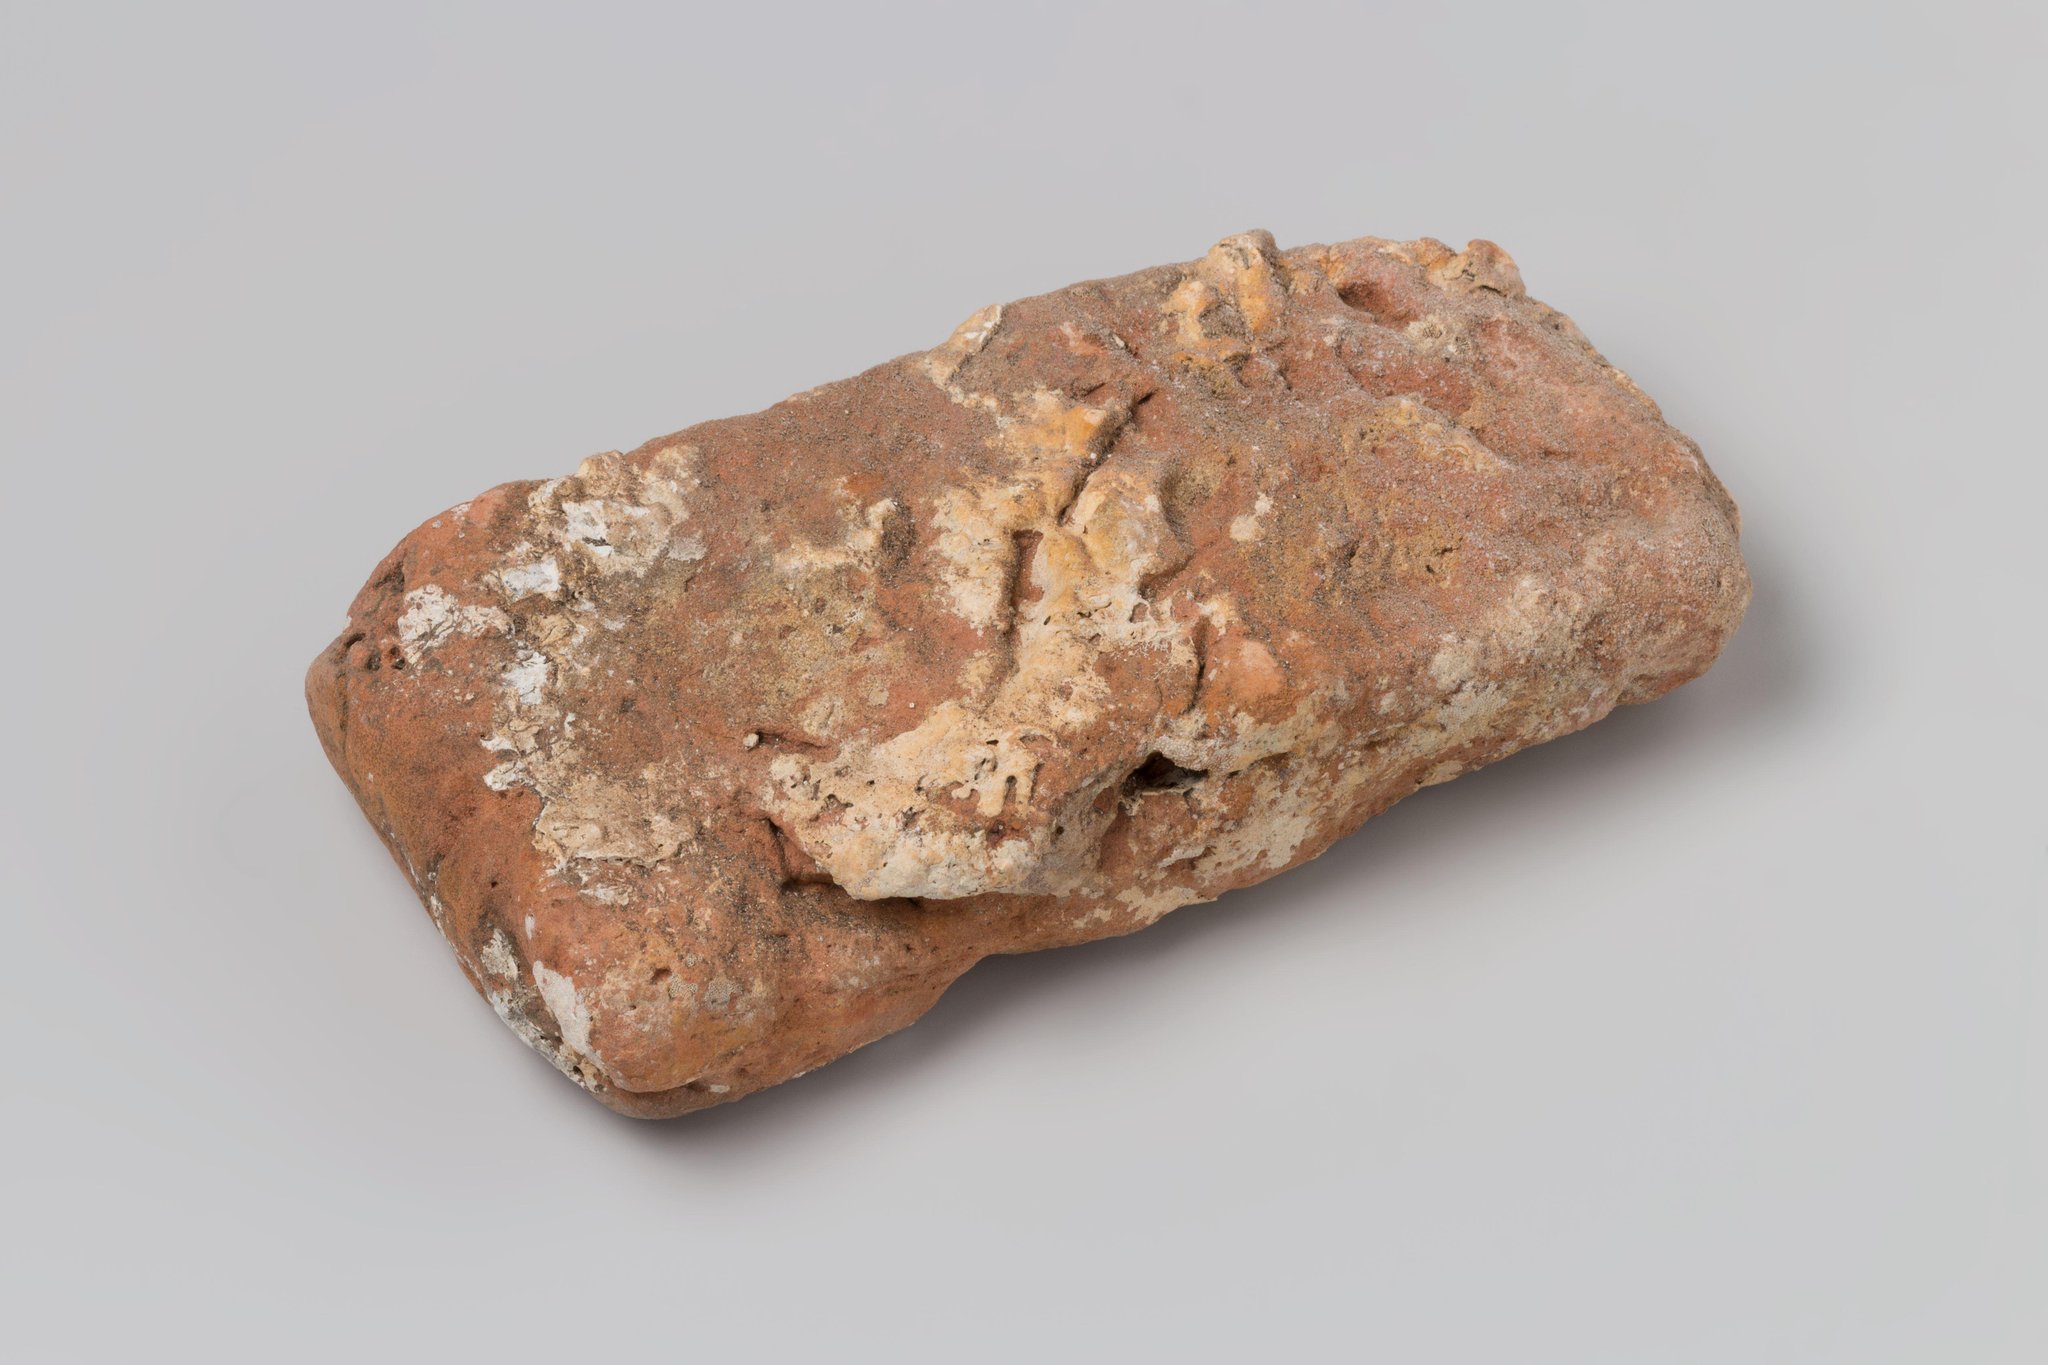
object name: brick clay product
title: Roodbruine baksteen uit V.O.C.-schip de 'Witte Leeuw'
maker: Anonymous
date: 1613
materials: brick